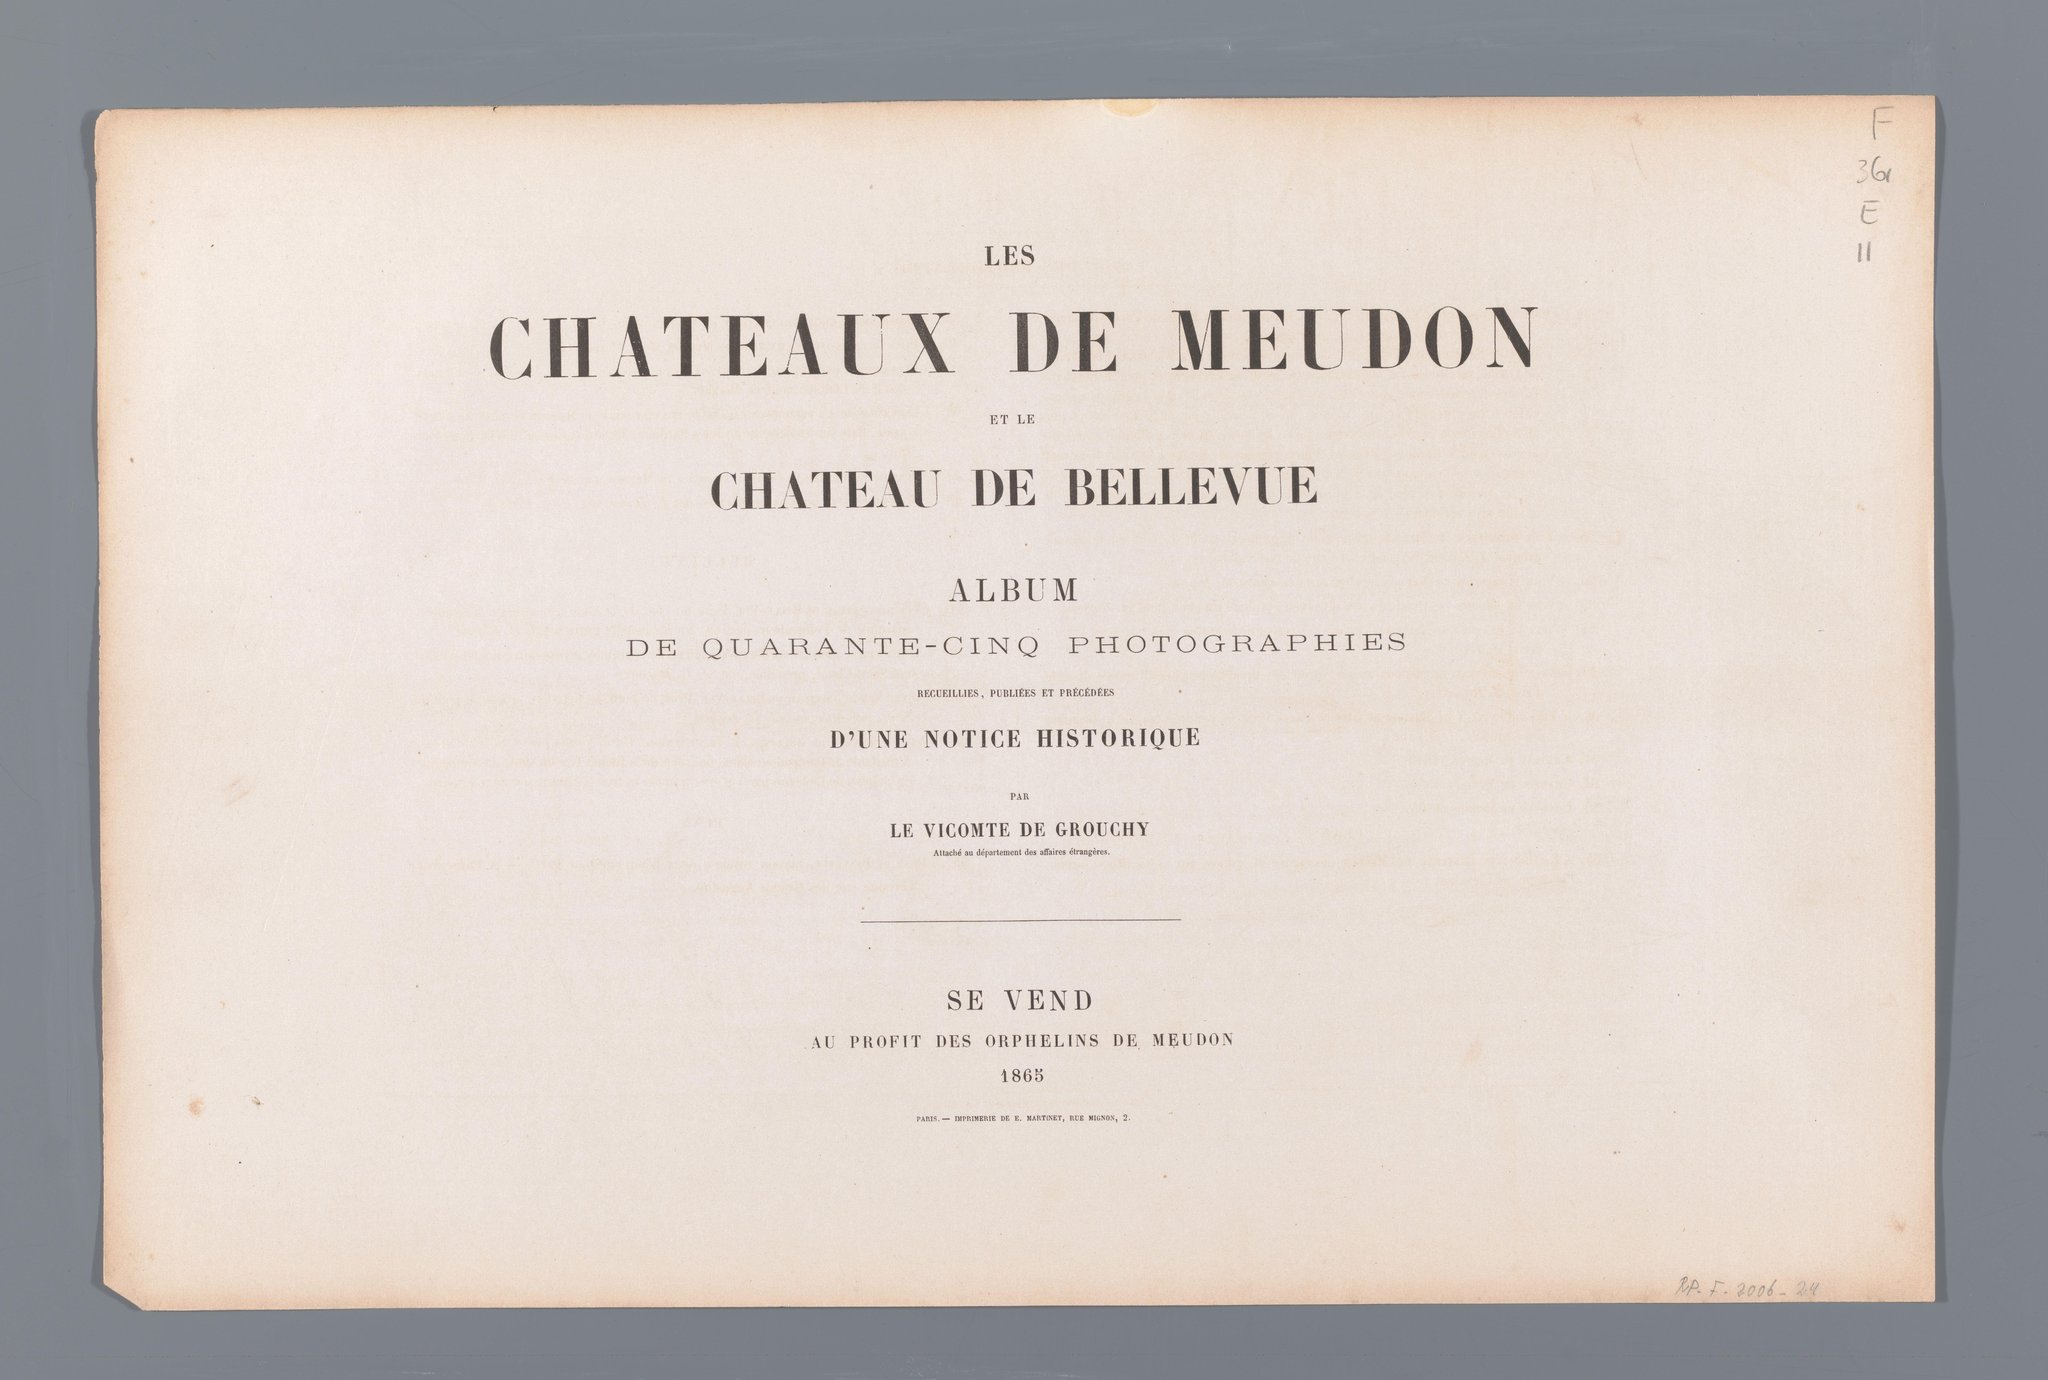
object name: wrapper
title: Les châteaux de Meudon et le château de Bellevue / rec., publ., et précédées d'une notice historique par le vicomte de Grouchy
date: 1865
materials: cardboard, linen, paper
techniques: photograph, printing